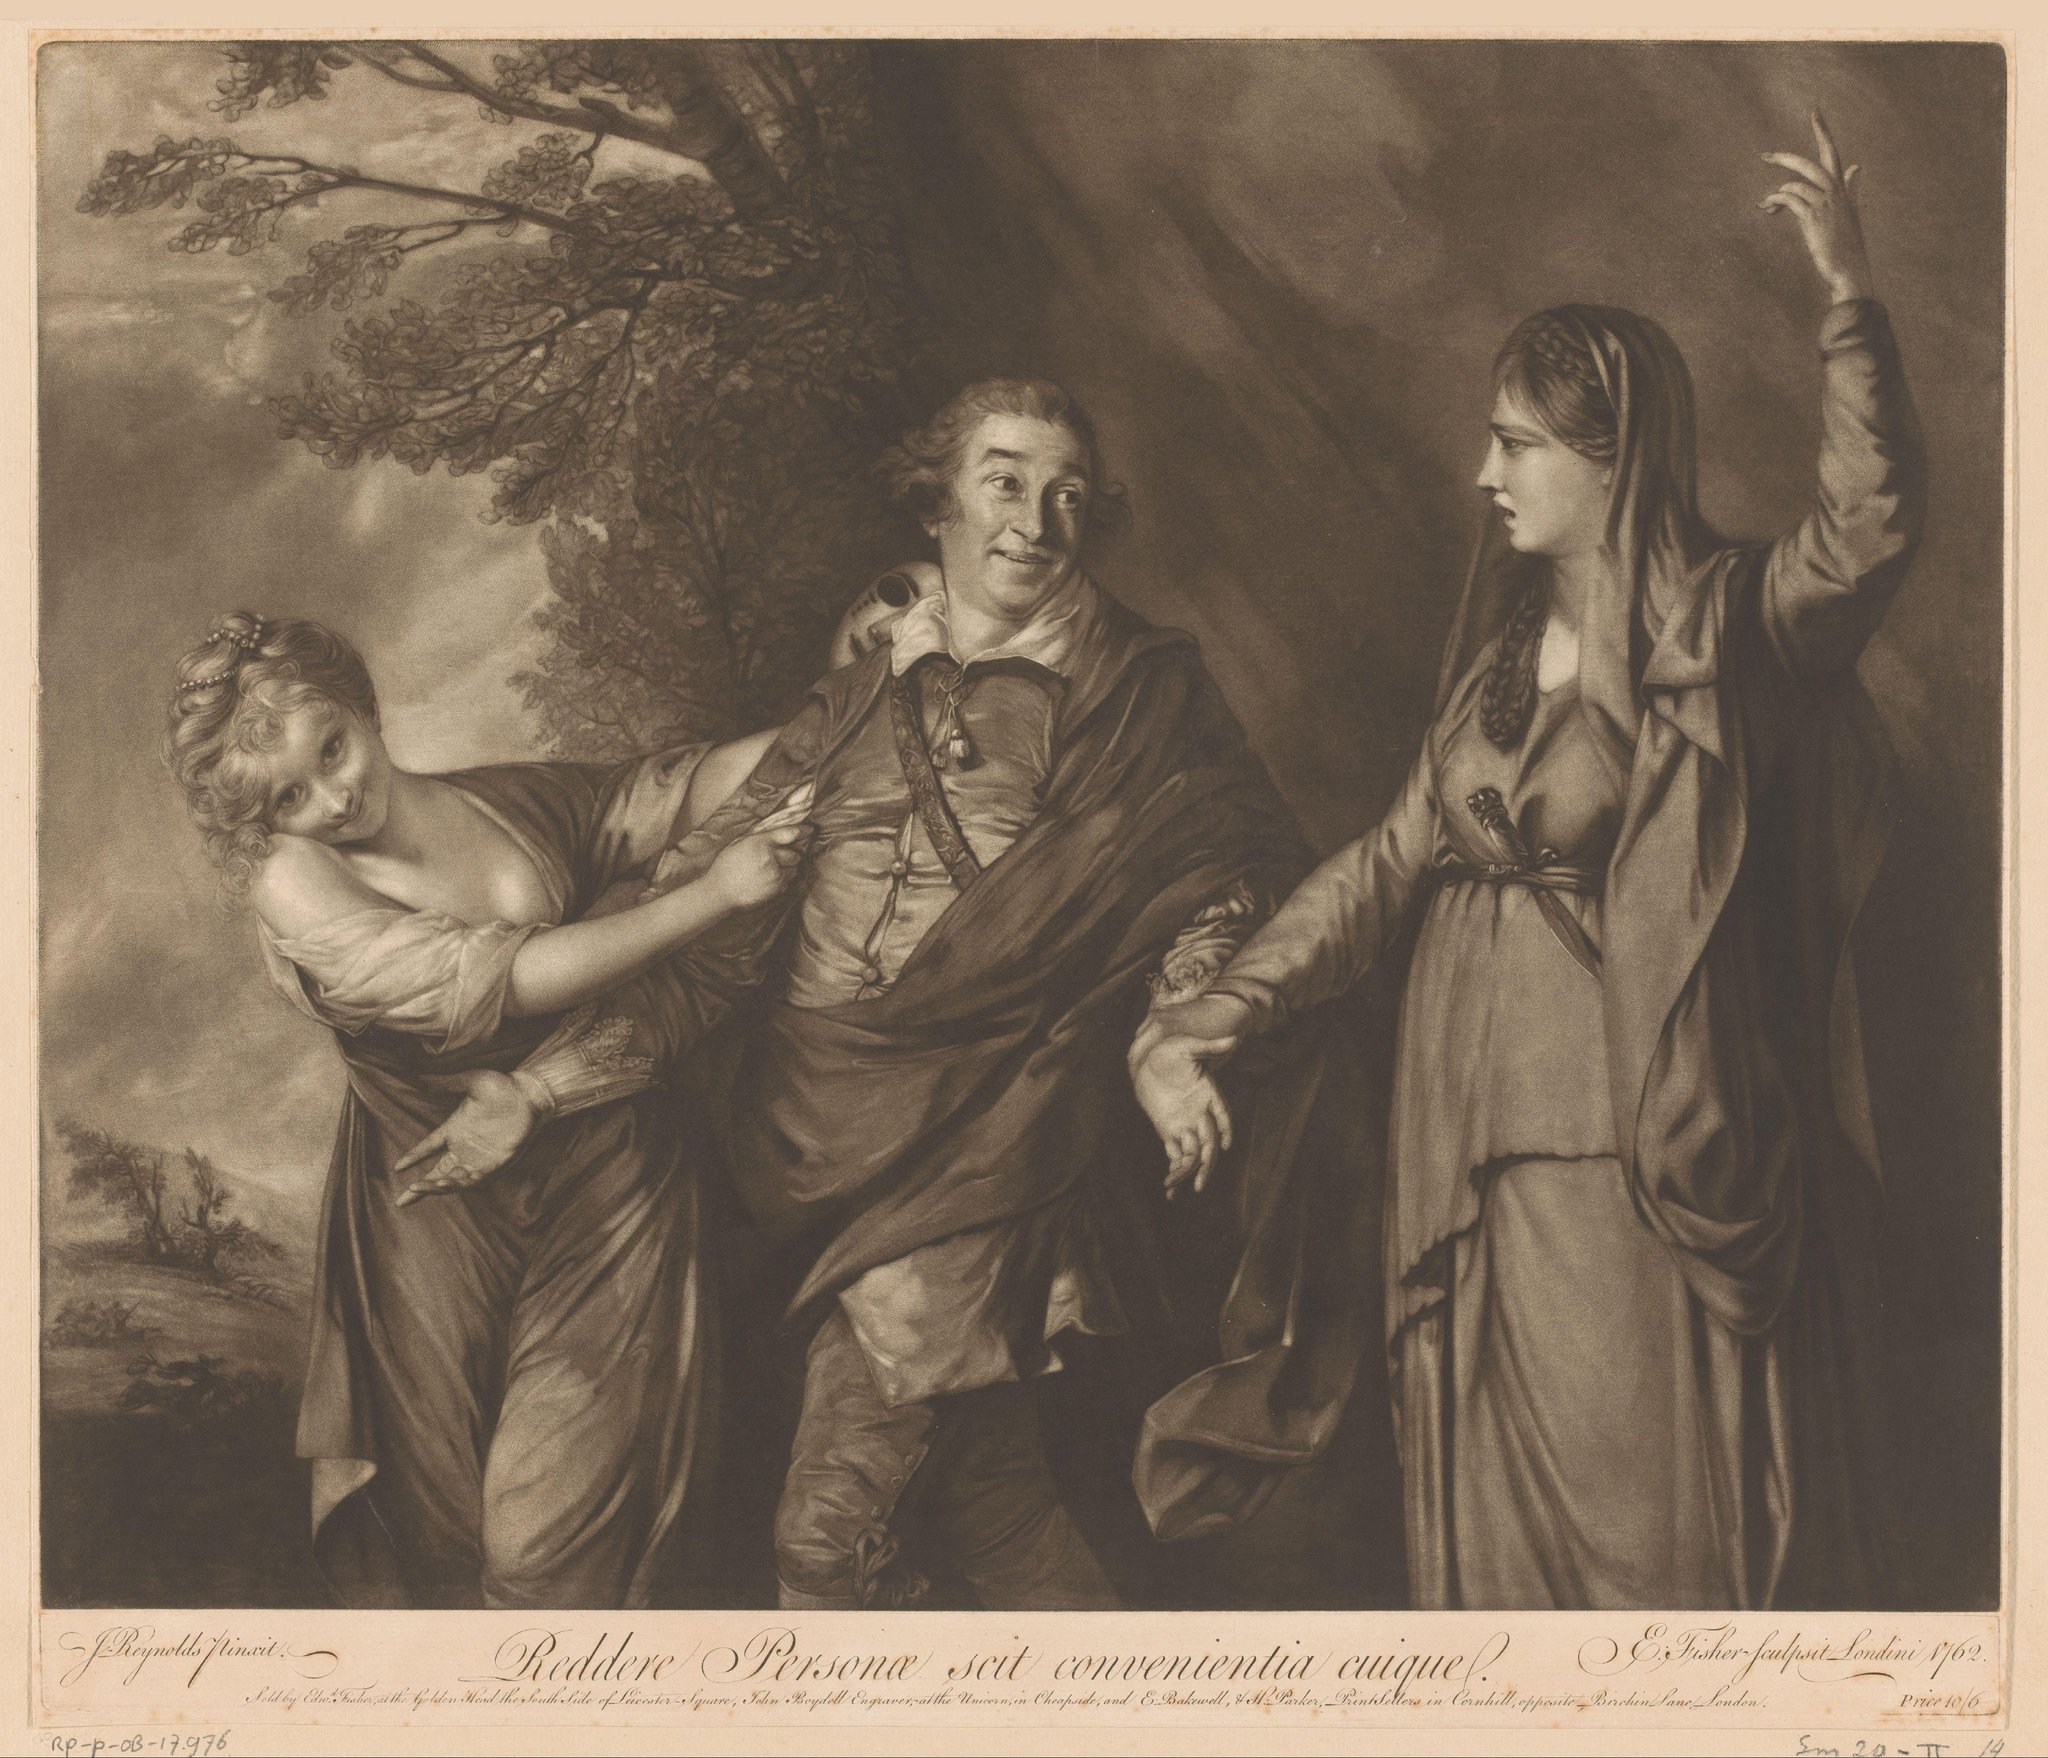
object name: print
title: Portret van David Garrick tussen komedie en tragedie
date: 1762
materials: paper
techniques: mezzotint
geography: london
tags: london, david garrick, historical persons, abstract ideas and concepts (+ abstract concept represented by female figure), portrait of actor, actress, tragedy, comedy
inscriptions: collector's mark: Lugt 240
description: Komedie, gepersonifieerd als een jonge, glimlachende vrouw, trekt Garrick aan zijn mouw. Garrick loopt met haar mee en kijkt richting de personificatie van tragedie. Zij heeft zijn pols vastgepakt en wijst met haar linkerhand naar boven. Haar wenkbrauwen zijn gefronst.